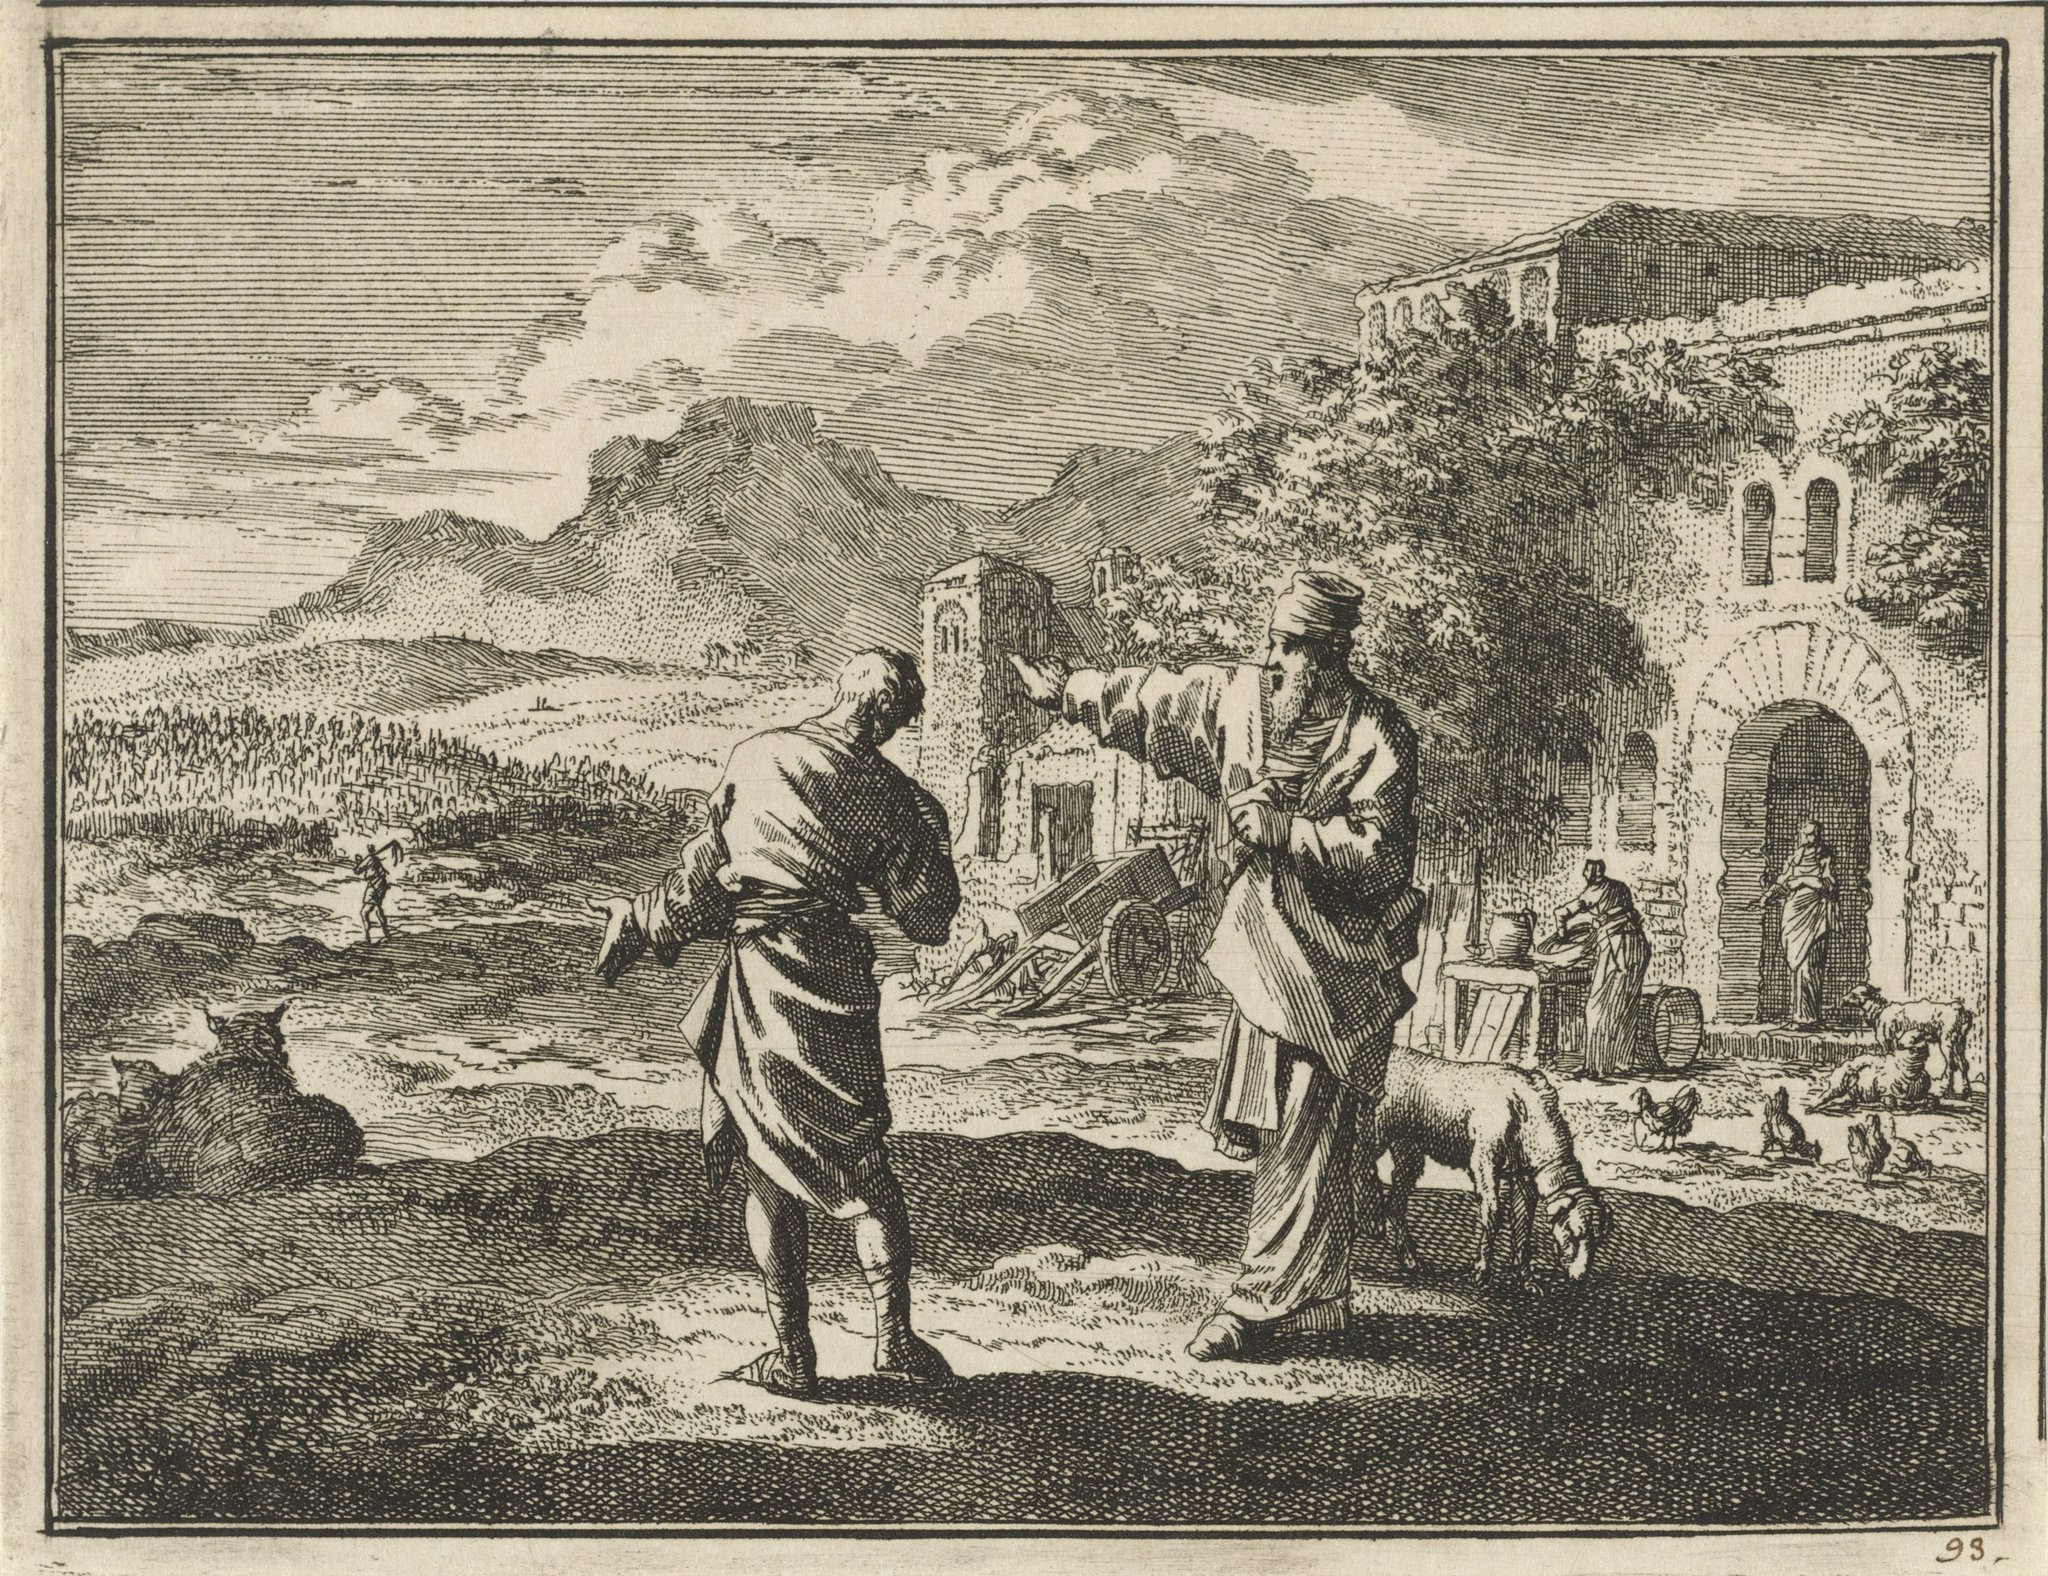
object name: print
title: Gelijkenis van de zoon die bevel krijgt naar de akker te gaan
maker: jan luyken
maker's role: draughtsman, print maker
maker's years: 1649-1712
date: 1712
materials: paper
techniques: etching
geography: amsterdam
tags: at last the lord sends his son, '... they cast him out of the vineyard, and killed him'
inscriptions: number: ‘99’, collector's mark: Lugt 2228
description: Proefdruk van illustratie uit: Luyken, Jan. De schriftuurlyke geschiedenissen en gelykenissen van het Oude en Nieuwe Verbond, 2 delen. Amsterdam: Wed. Pieter Arentsz II en Cornelis van der Sys, 1712, dl. II.